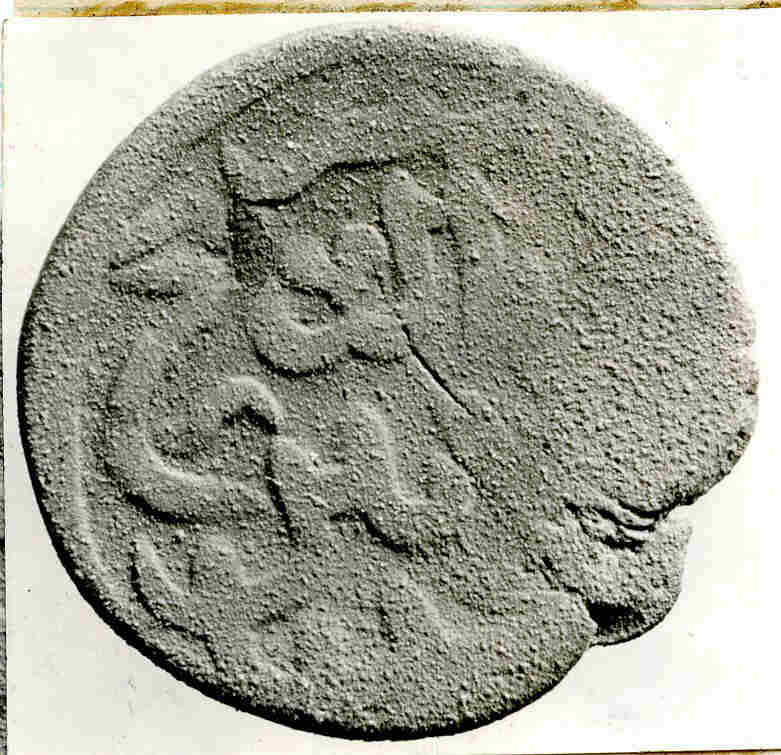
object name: coin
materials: copper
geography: uzbekistan